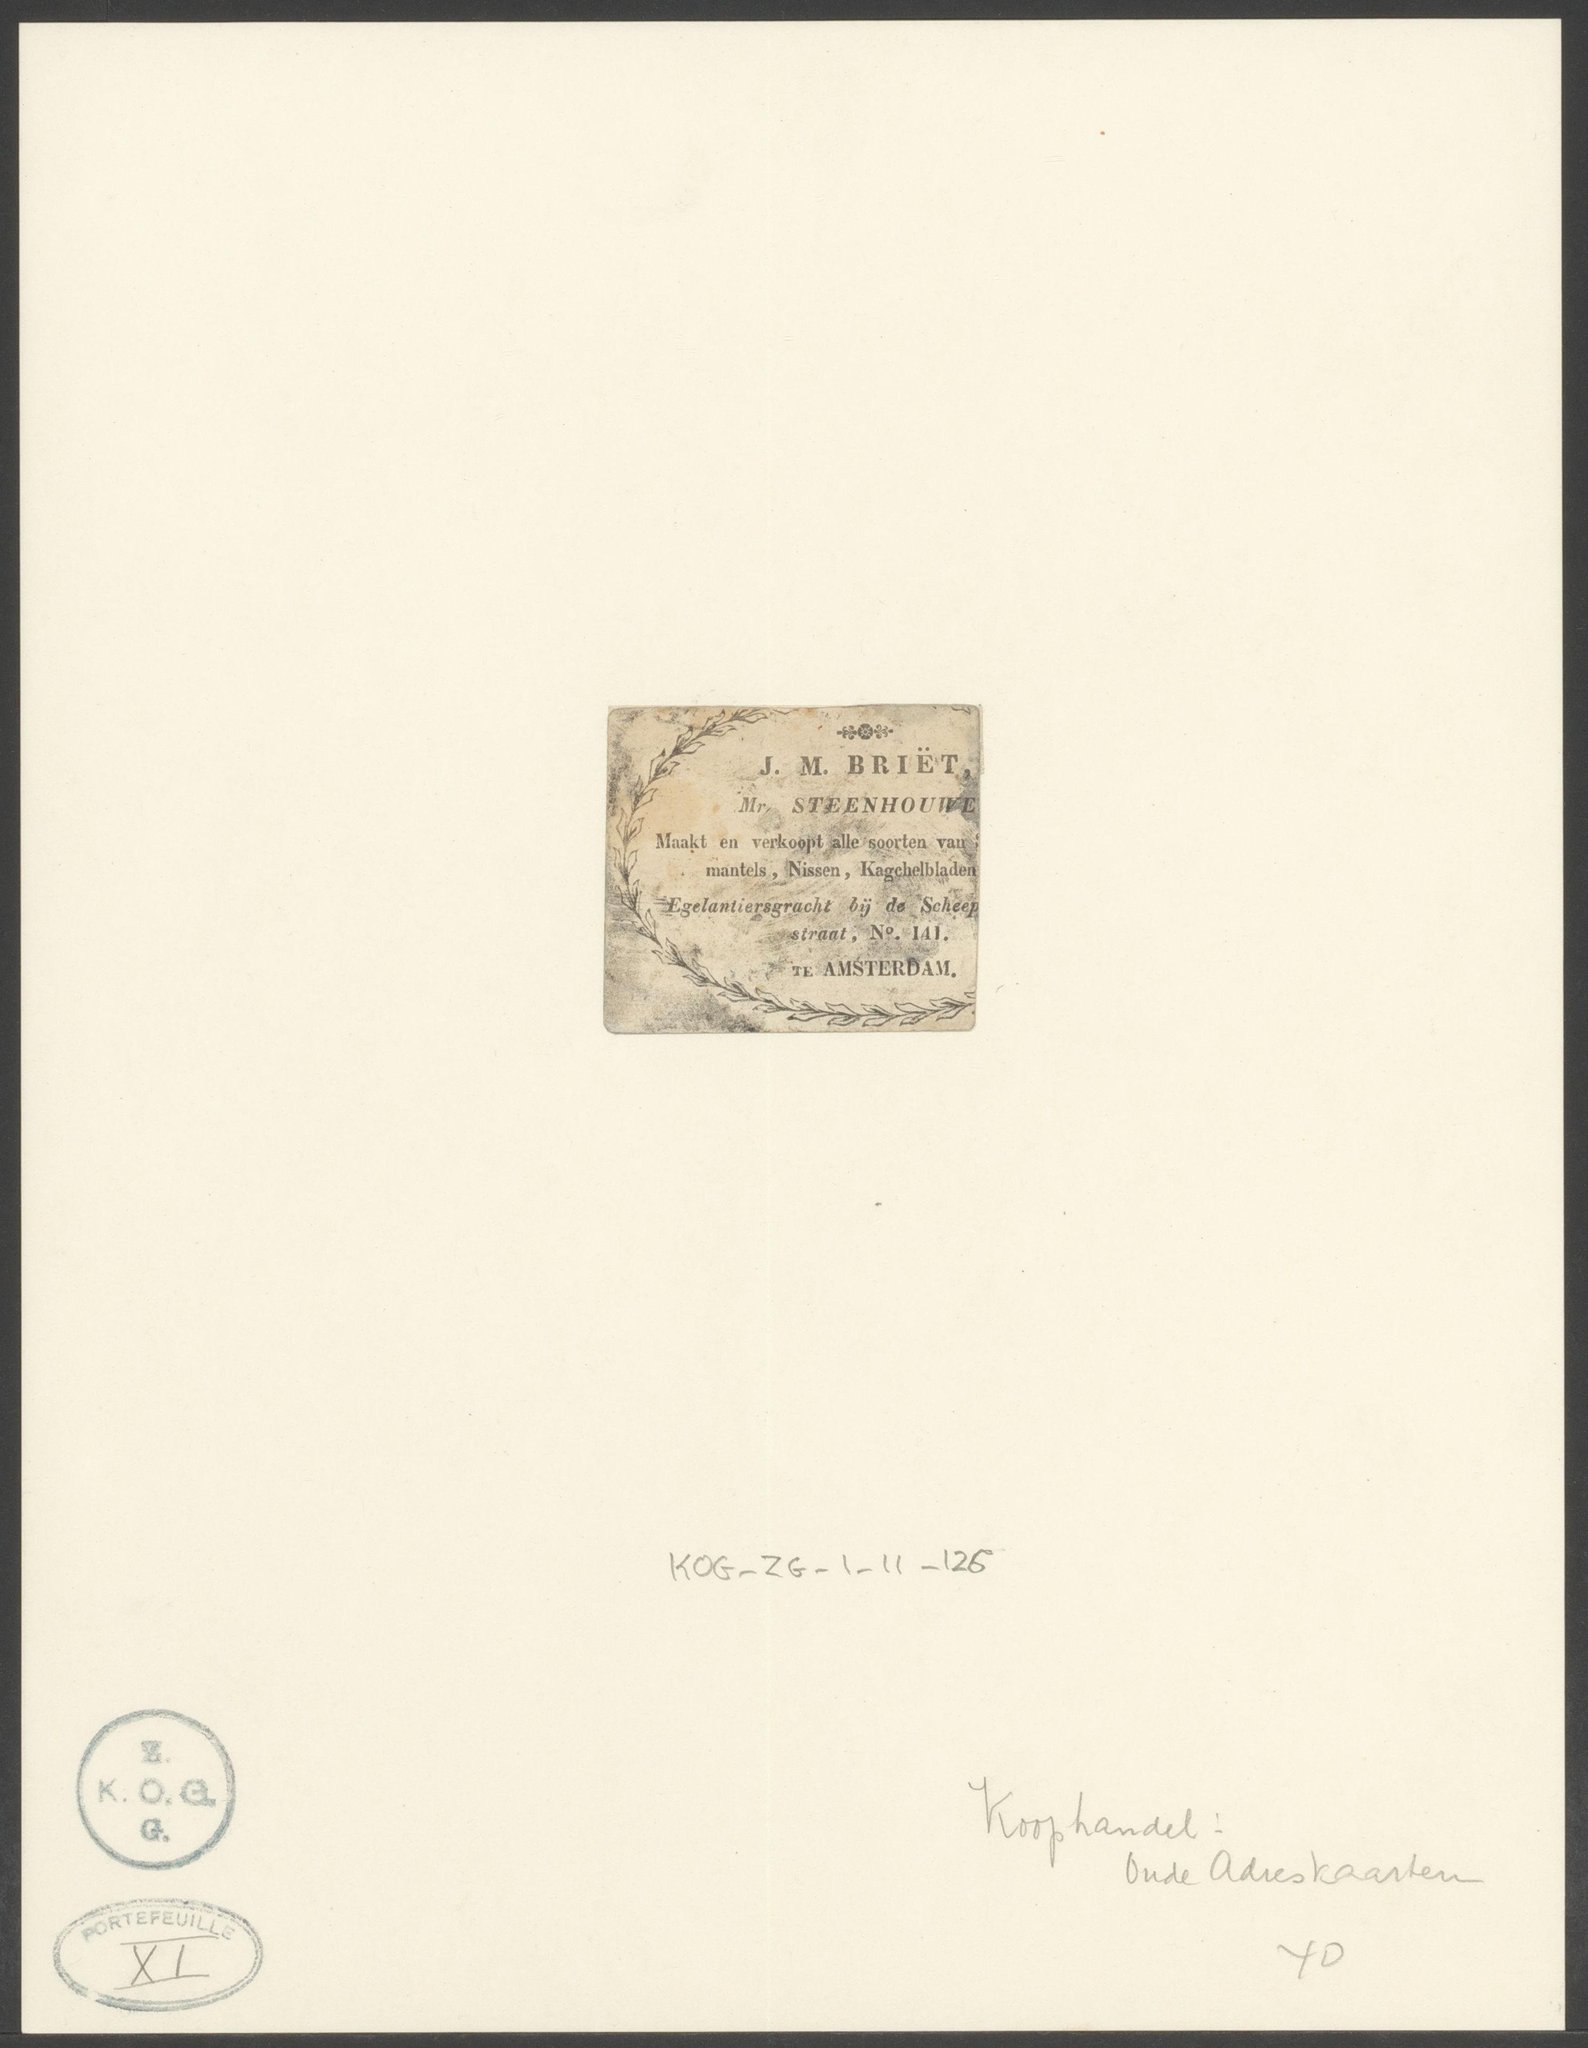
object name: text sheet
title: Visitekaartje van J.M. Briët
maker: Anonymous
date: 1870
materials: paper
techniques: letterpress printing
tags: merchant, salesman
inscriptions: stamp, collector's mark: Lugt 1641b, collector's mark: Lugt 1641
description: Visitekaartje van J.M. Briët. Briët is steenhouwer en maakt mantels, nissen en kachelbladen. Onderwerpsrubrieken binnen de Atlas Zeden en Gewoonten: Handel, nijverheid en verkeer, Koophandel, Veilingen, Makelaardij en Verzekeringswezen, Oude adreskaarten van winkels en fabrieken, reclame.